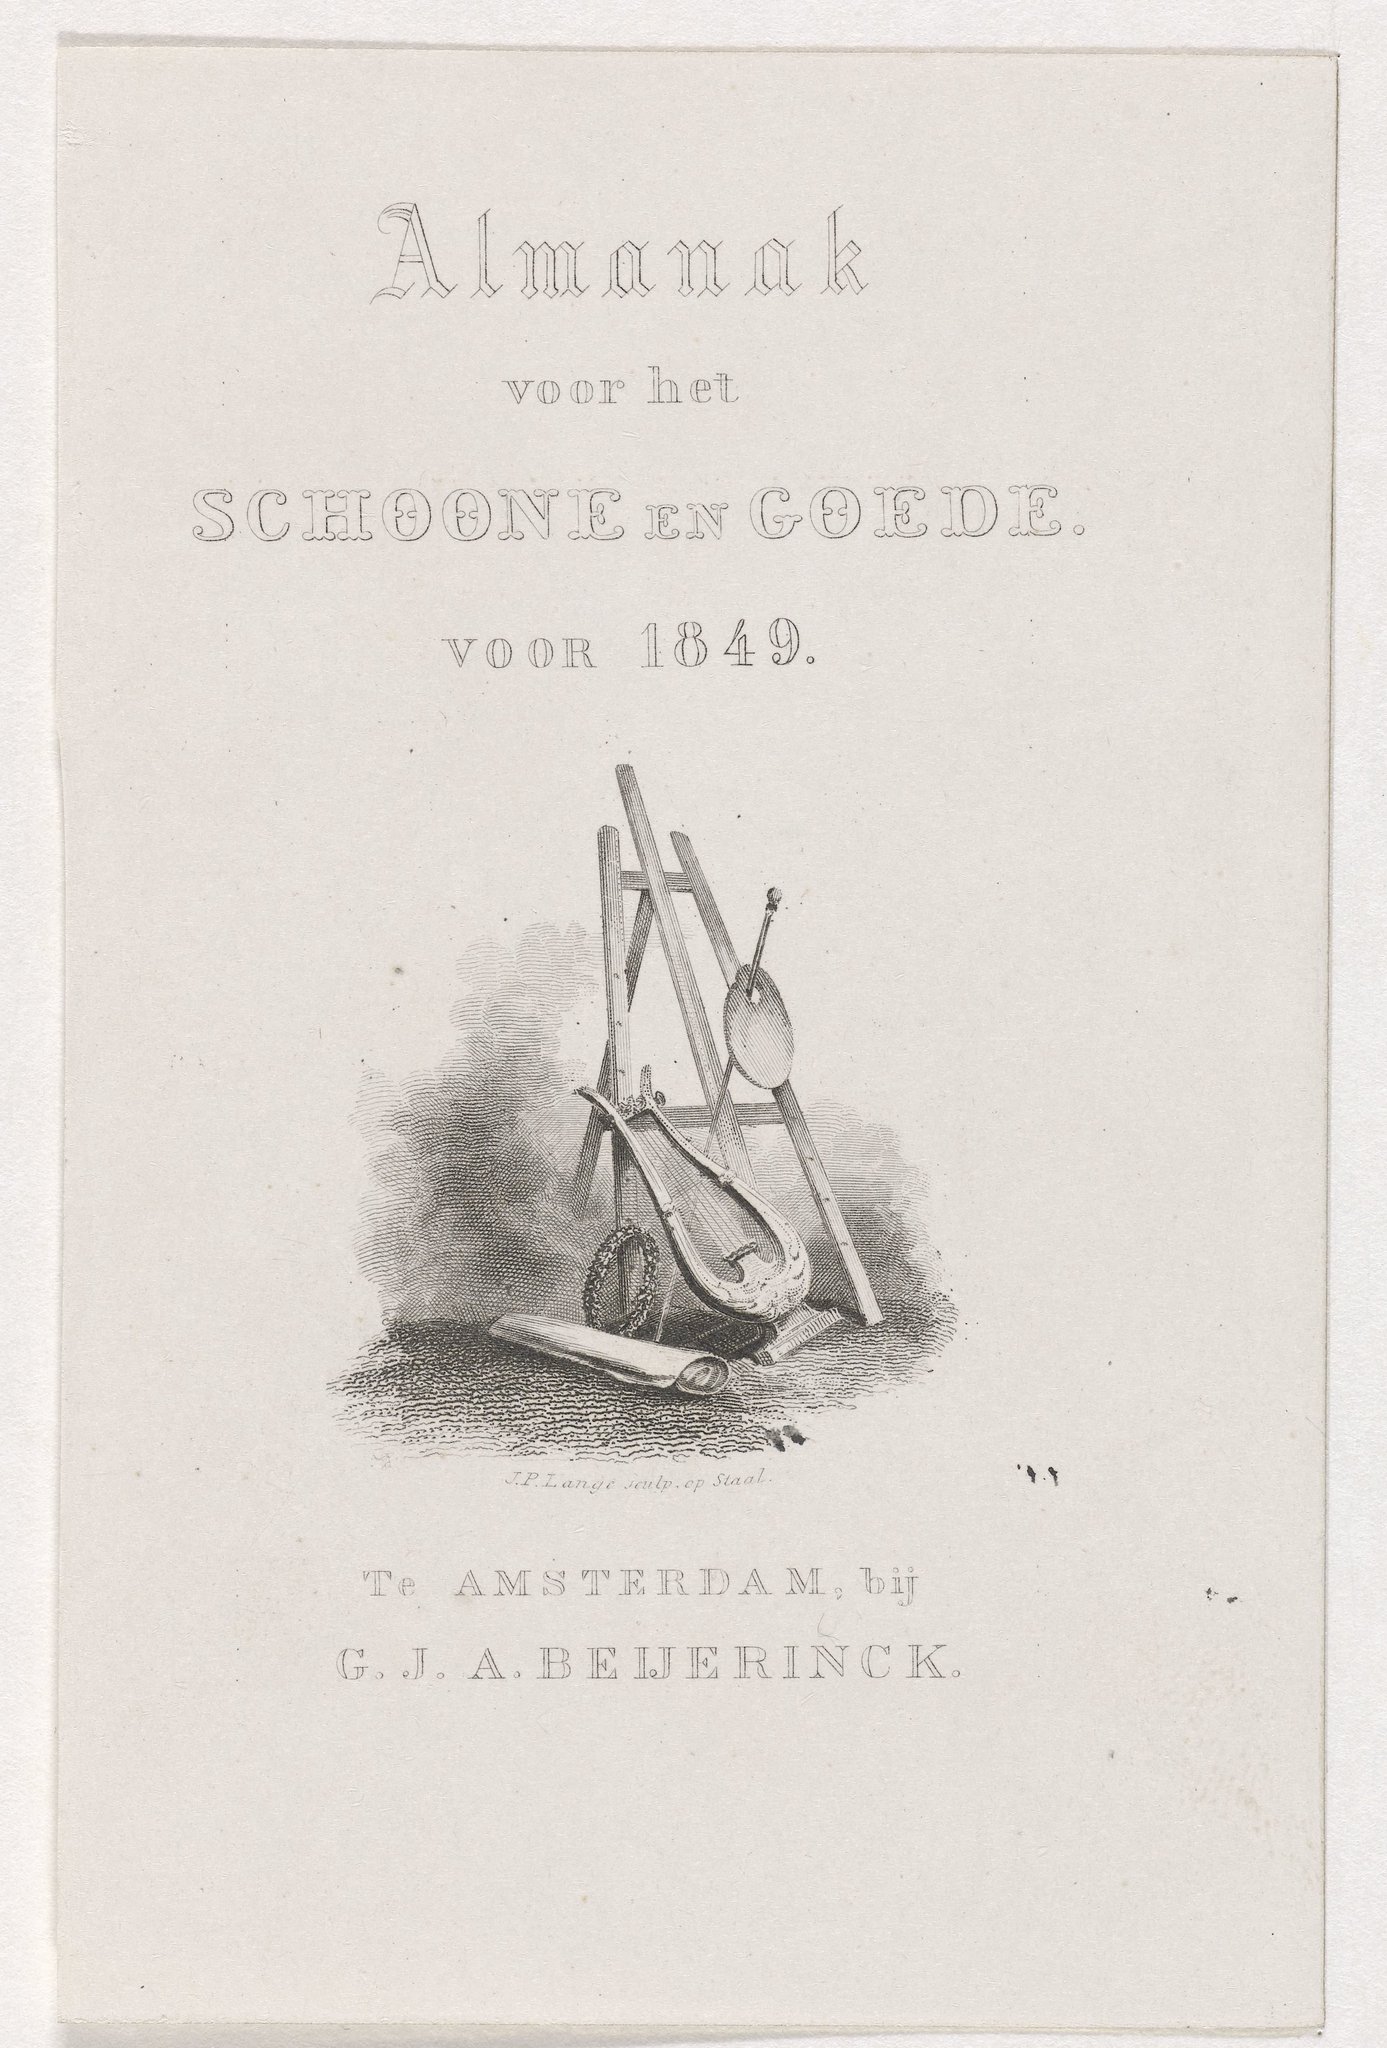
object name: print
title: Compositie van schildersattributen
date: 1849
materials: paper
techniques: engraving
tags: tools, implements of painter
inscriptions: collector's mark: Lugt 2228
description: Compositie van een schildersezel, schilderspalet en schilderstok, een lier, laurierkrans en een opgerold vel papier.